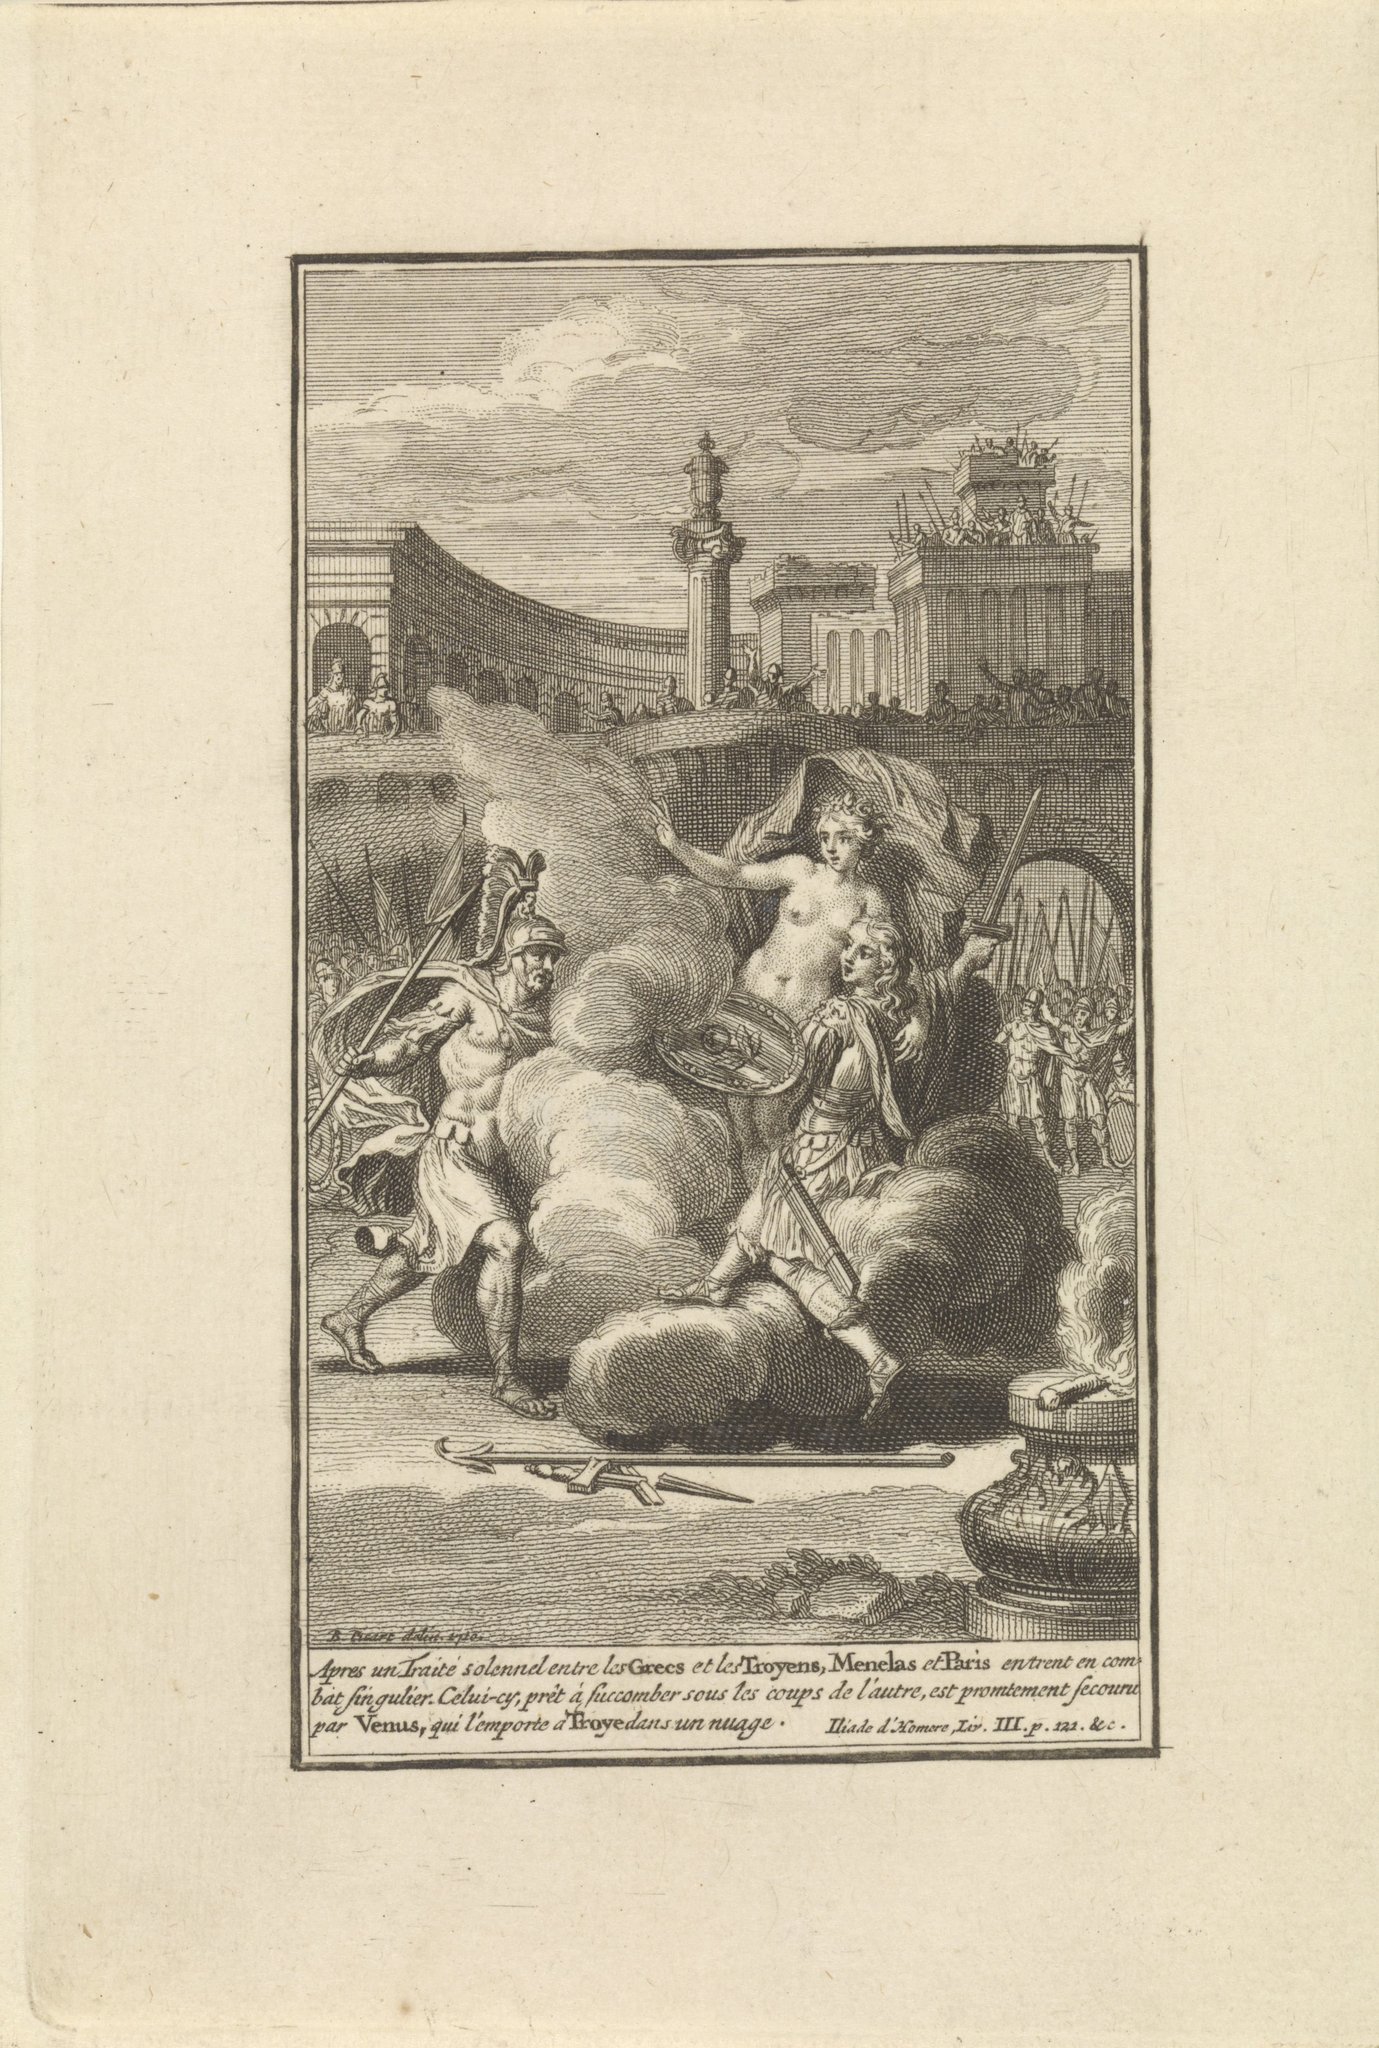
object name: print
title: Het gevecht tussen Menelaos en Paris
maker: bernard picart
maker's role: draughtsman, print maker, publisher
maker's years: 1673-1733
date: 1710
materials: paper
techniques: engraving, etching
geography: amsterdam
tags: venus intervenes in the duel between paris and menelaus: she covers paris with a cloud and leads him to his room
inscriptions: collector's mark: Lugt 2228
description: Koning Menelaos en Paris vechten om Helena. Venus hult Paris in een wolk om hem te redden zodat hij niet verliest. In de marge een onderschrift in het Frans.